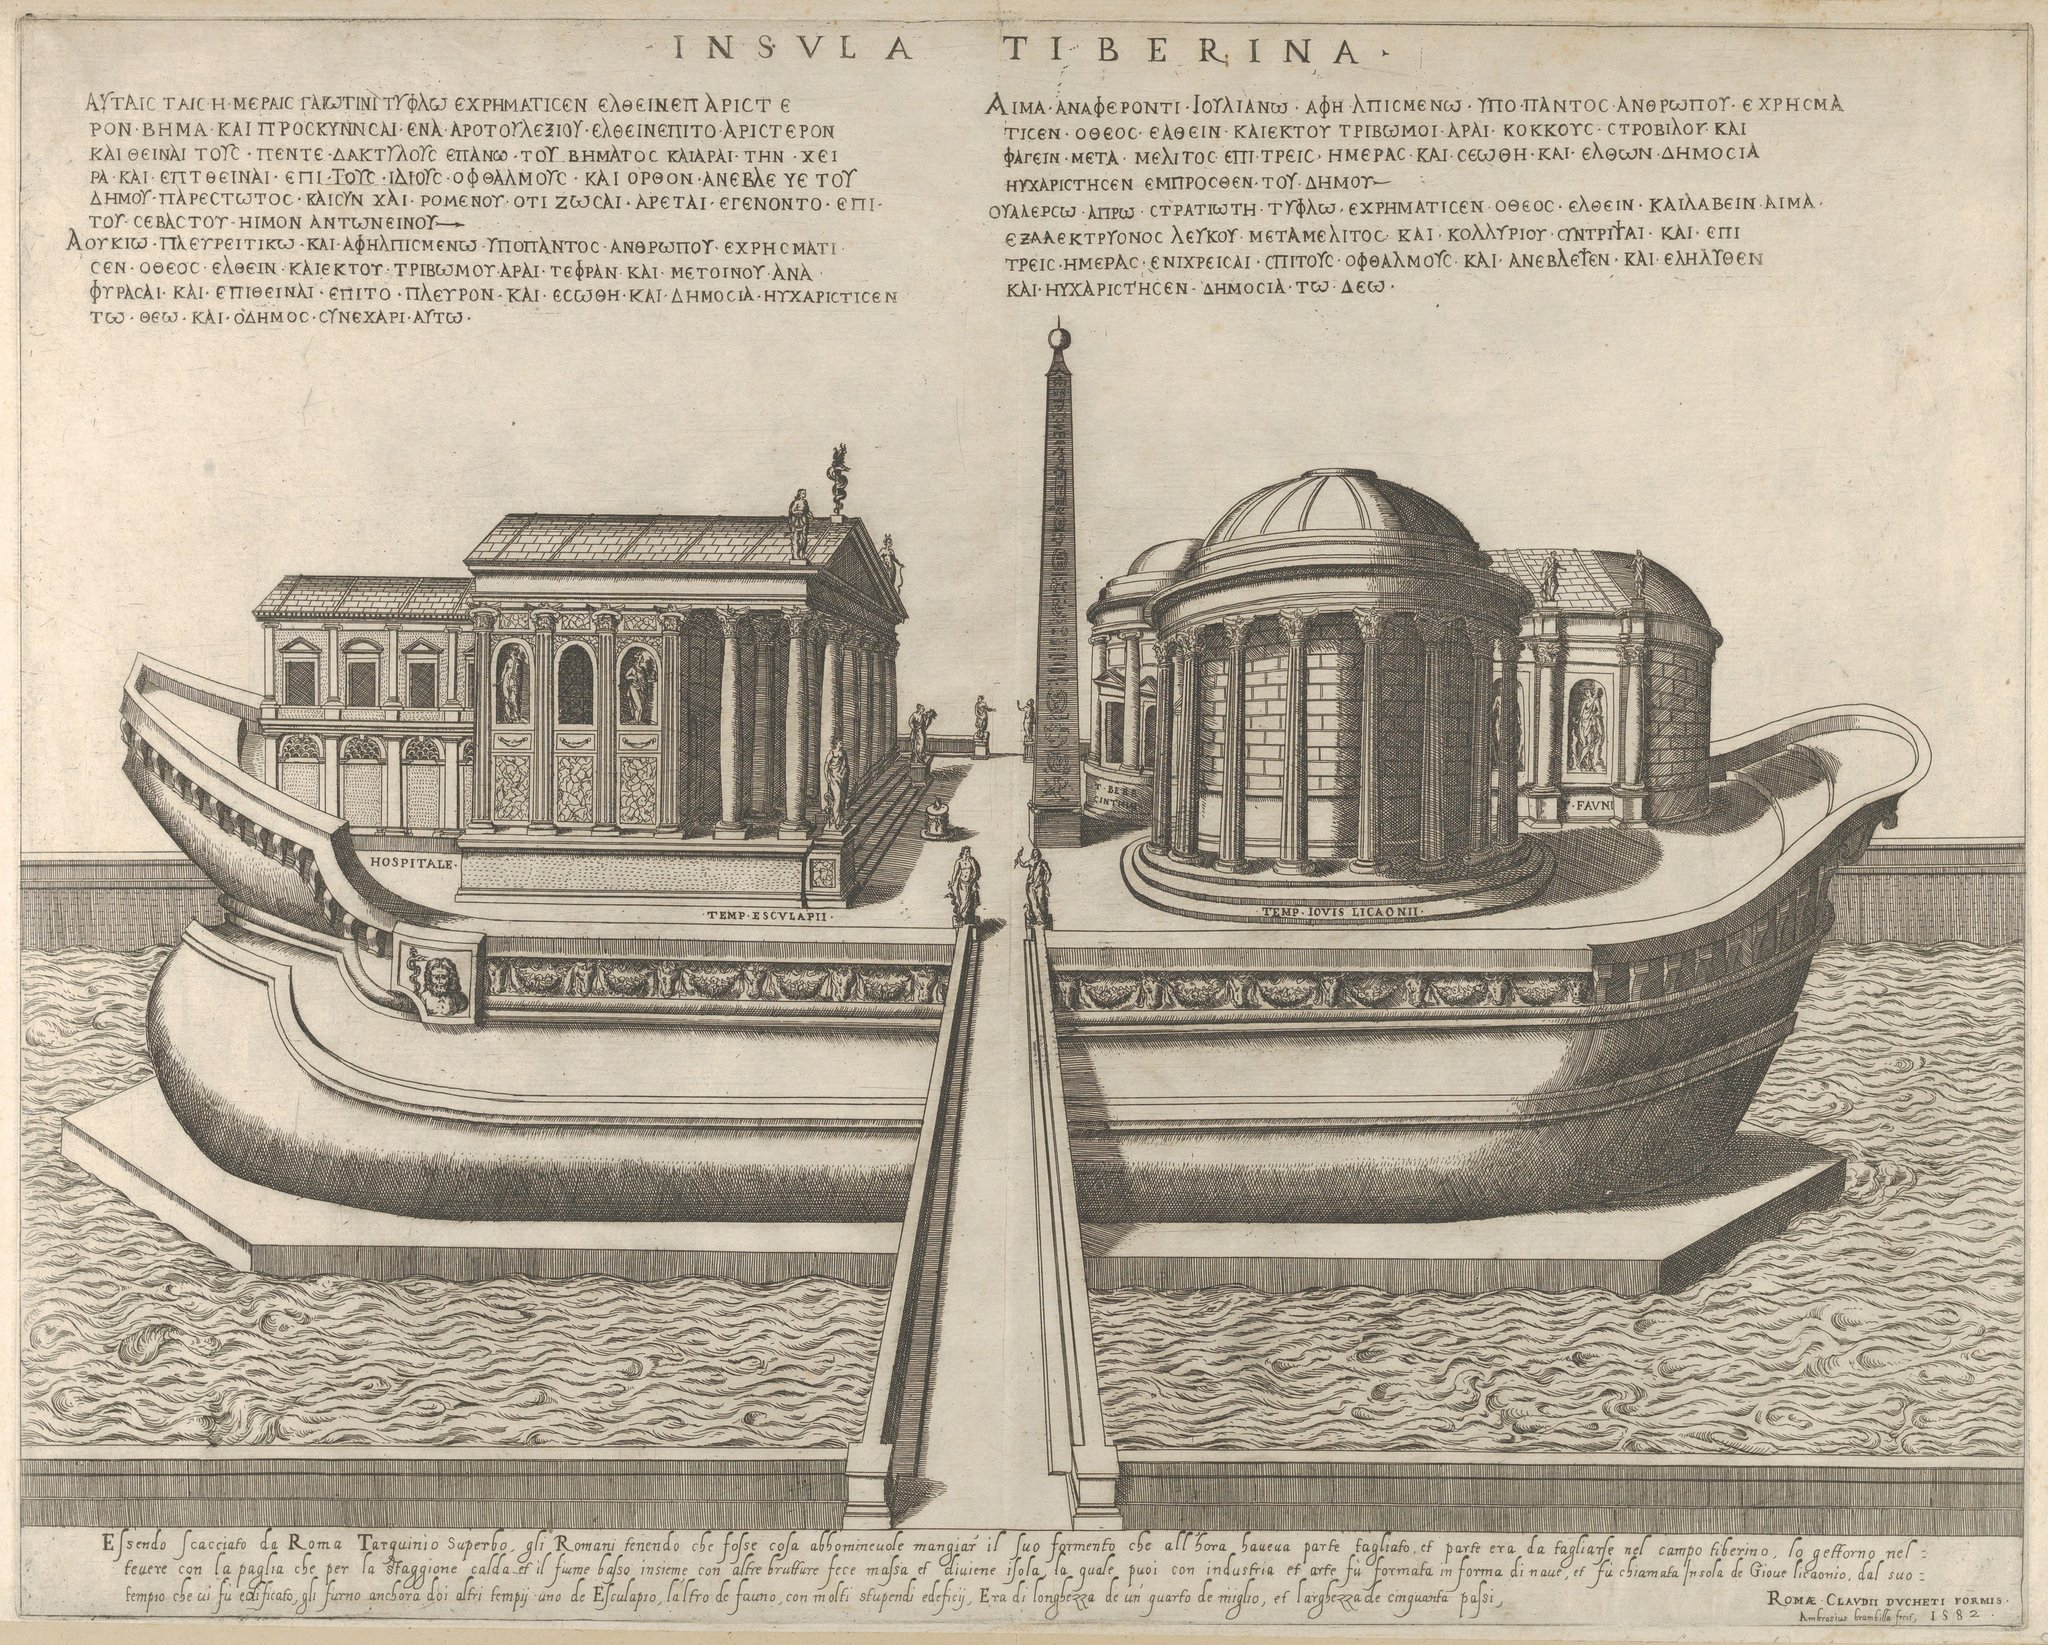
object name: print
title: View of the Tiber Island represented as a ship, the Temple of Aesculapius at left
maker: giovanni ambrogio brambilla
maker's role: artist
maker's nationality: italian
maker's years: 1575-1599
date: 1582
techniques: engraving, etching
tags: obelisks,temples,ships